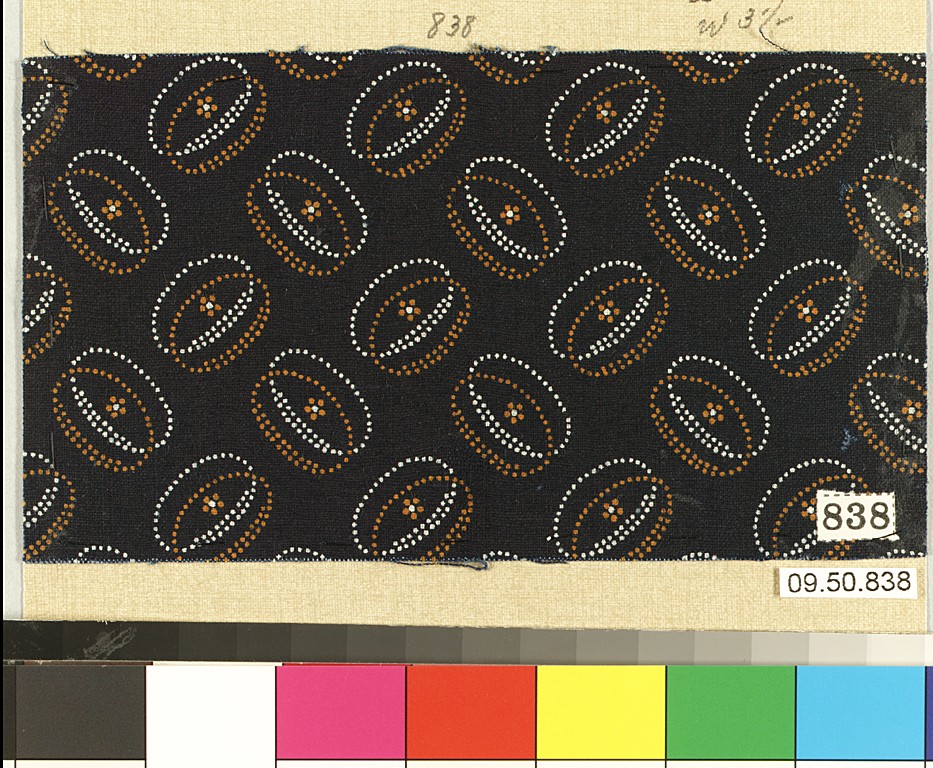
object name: piece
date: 1801-1900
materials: cotton